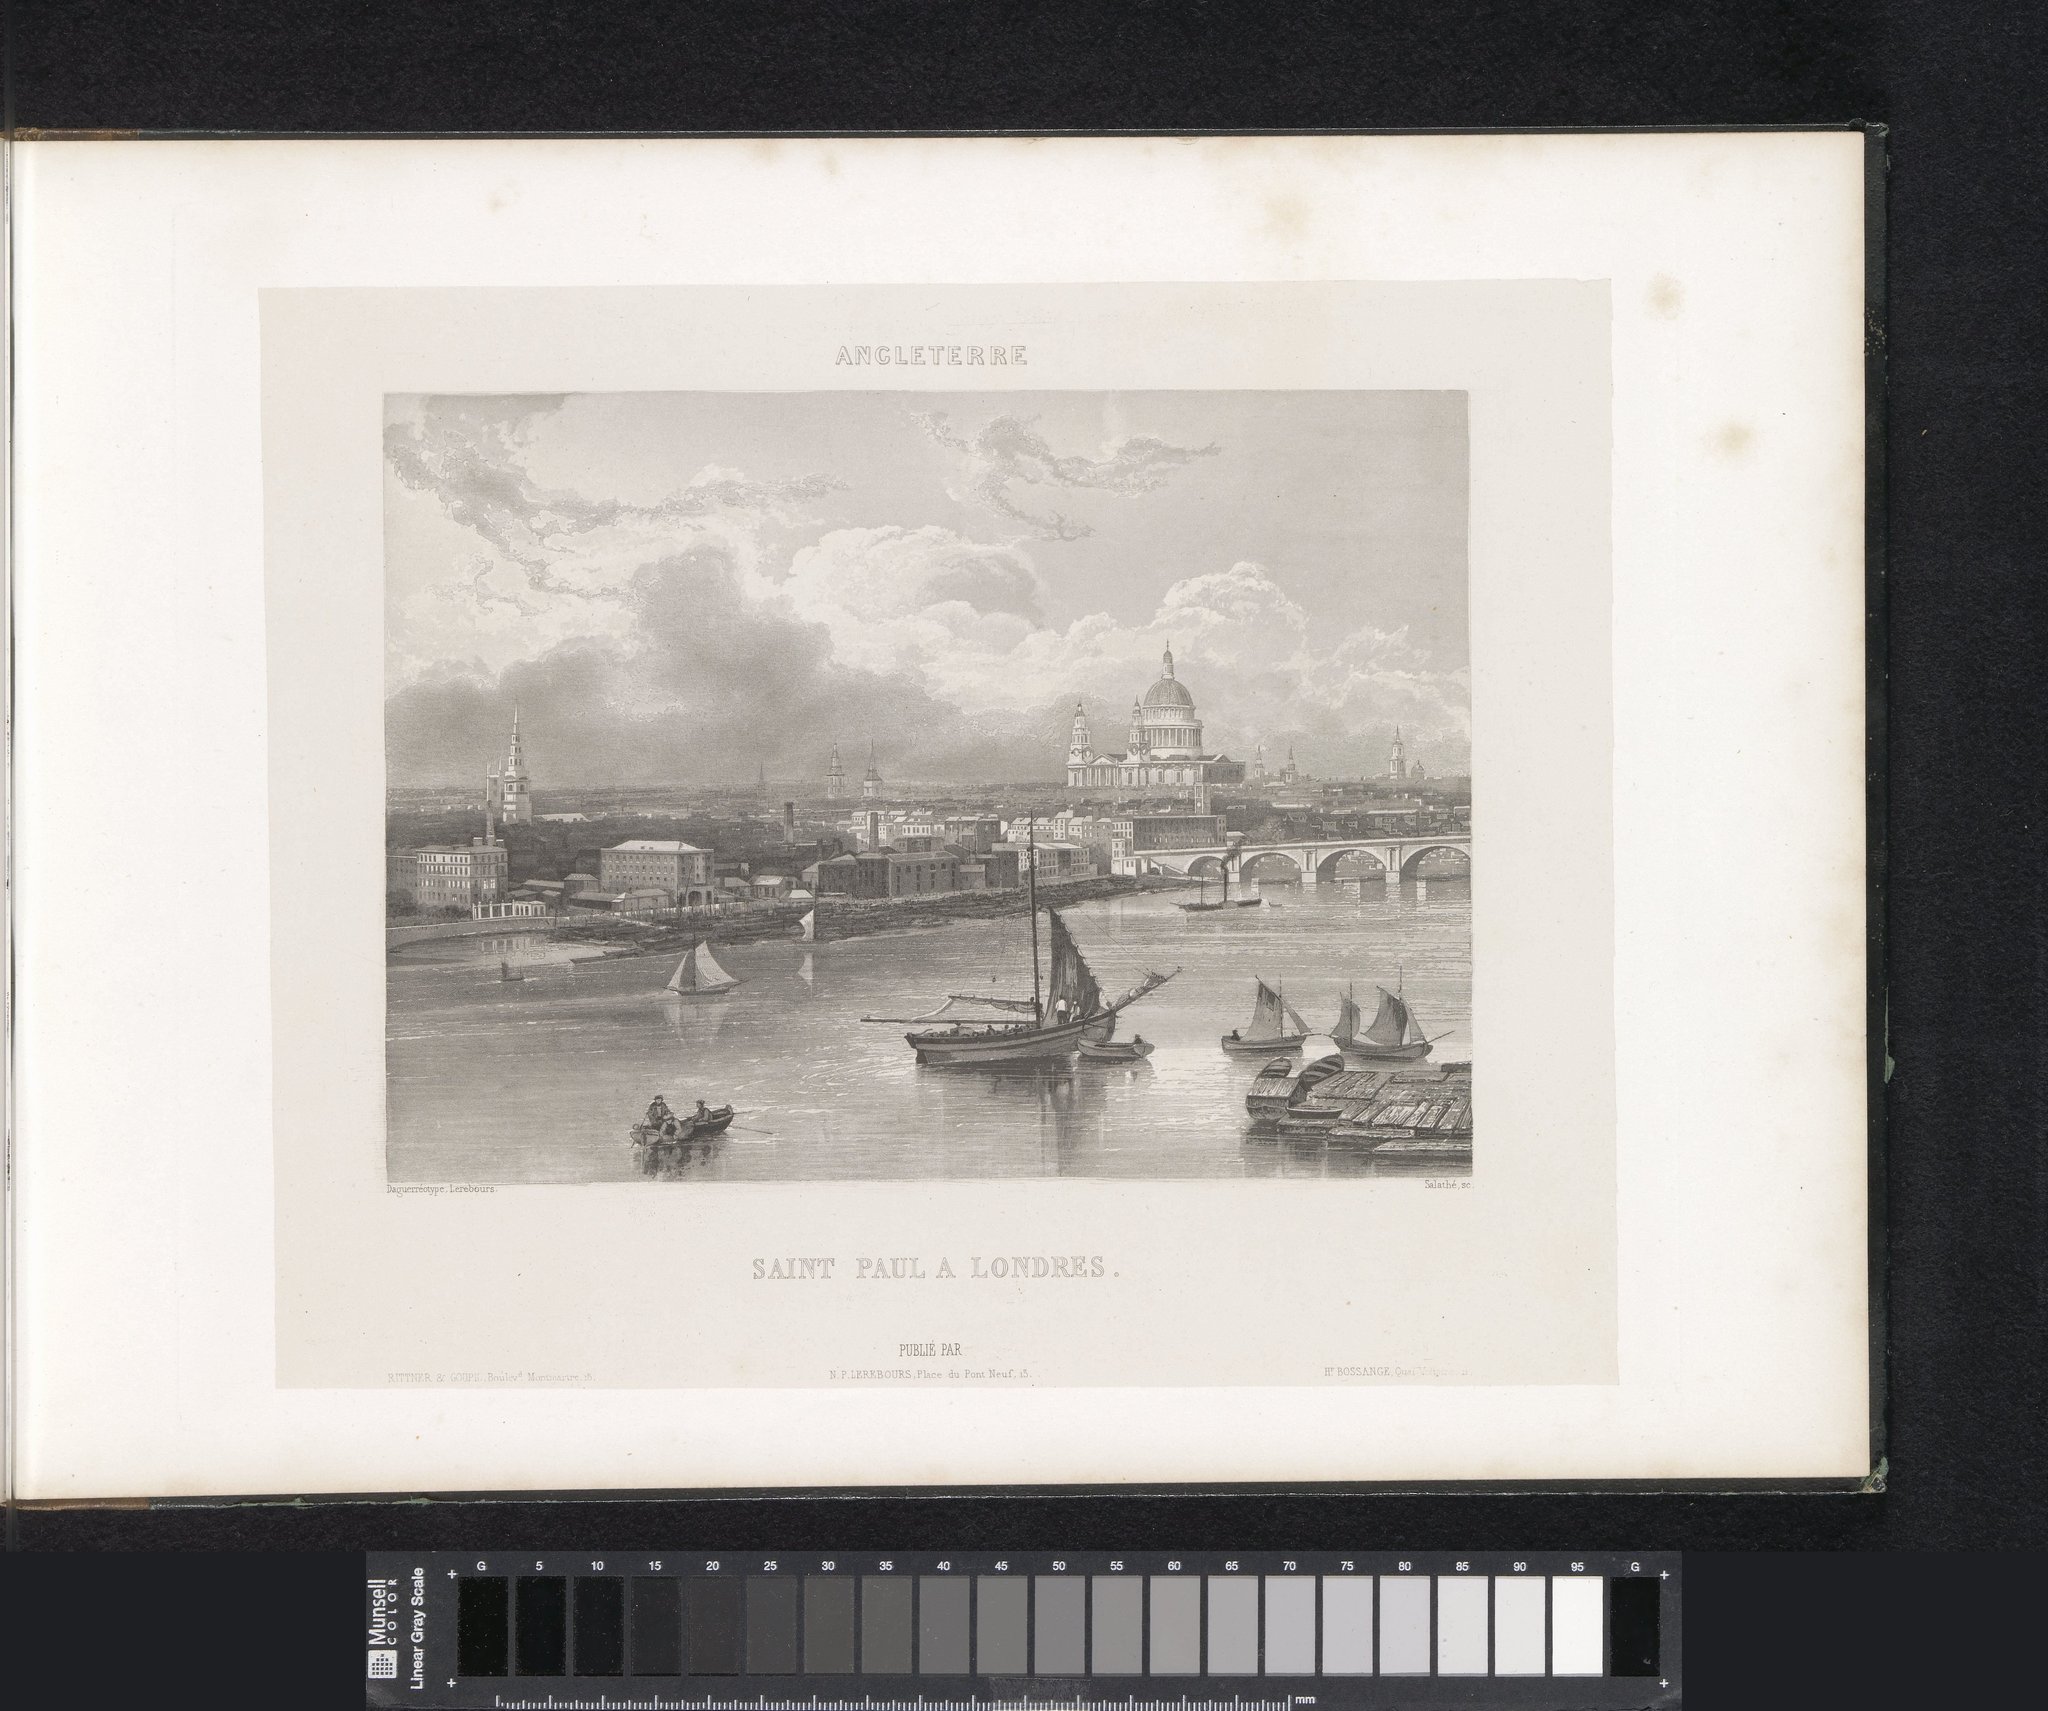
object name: print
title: Gezicht op de Theems te Londen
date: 1839-1841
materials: paper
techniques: aquatint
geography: paris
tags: city-view in general; 'veduta', river, london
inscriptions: inscription: ‘Rittner & Goupil Boulevd Montmartre 15’, inscription: ‘N.P. Lerebours Place du Pont Neuf 15’, inscription: ‘Hr. Bossance Quai Voltaire 11’